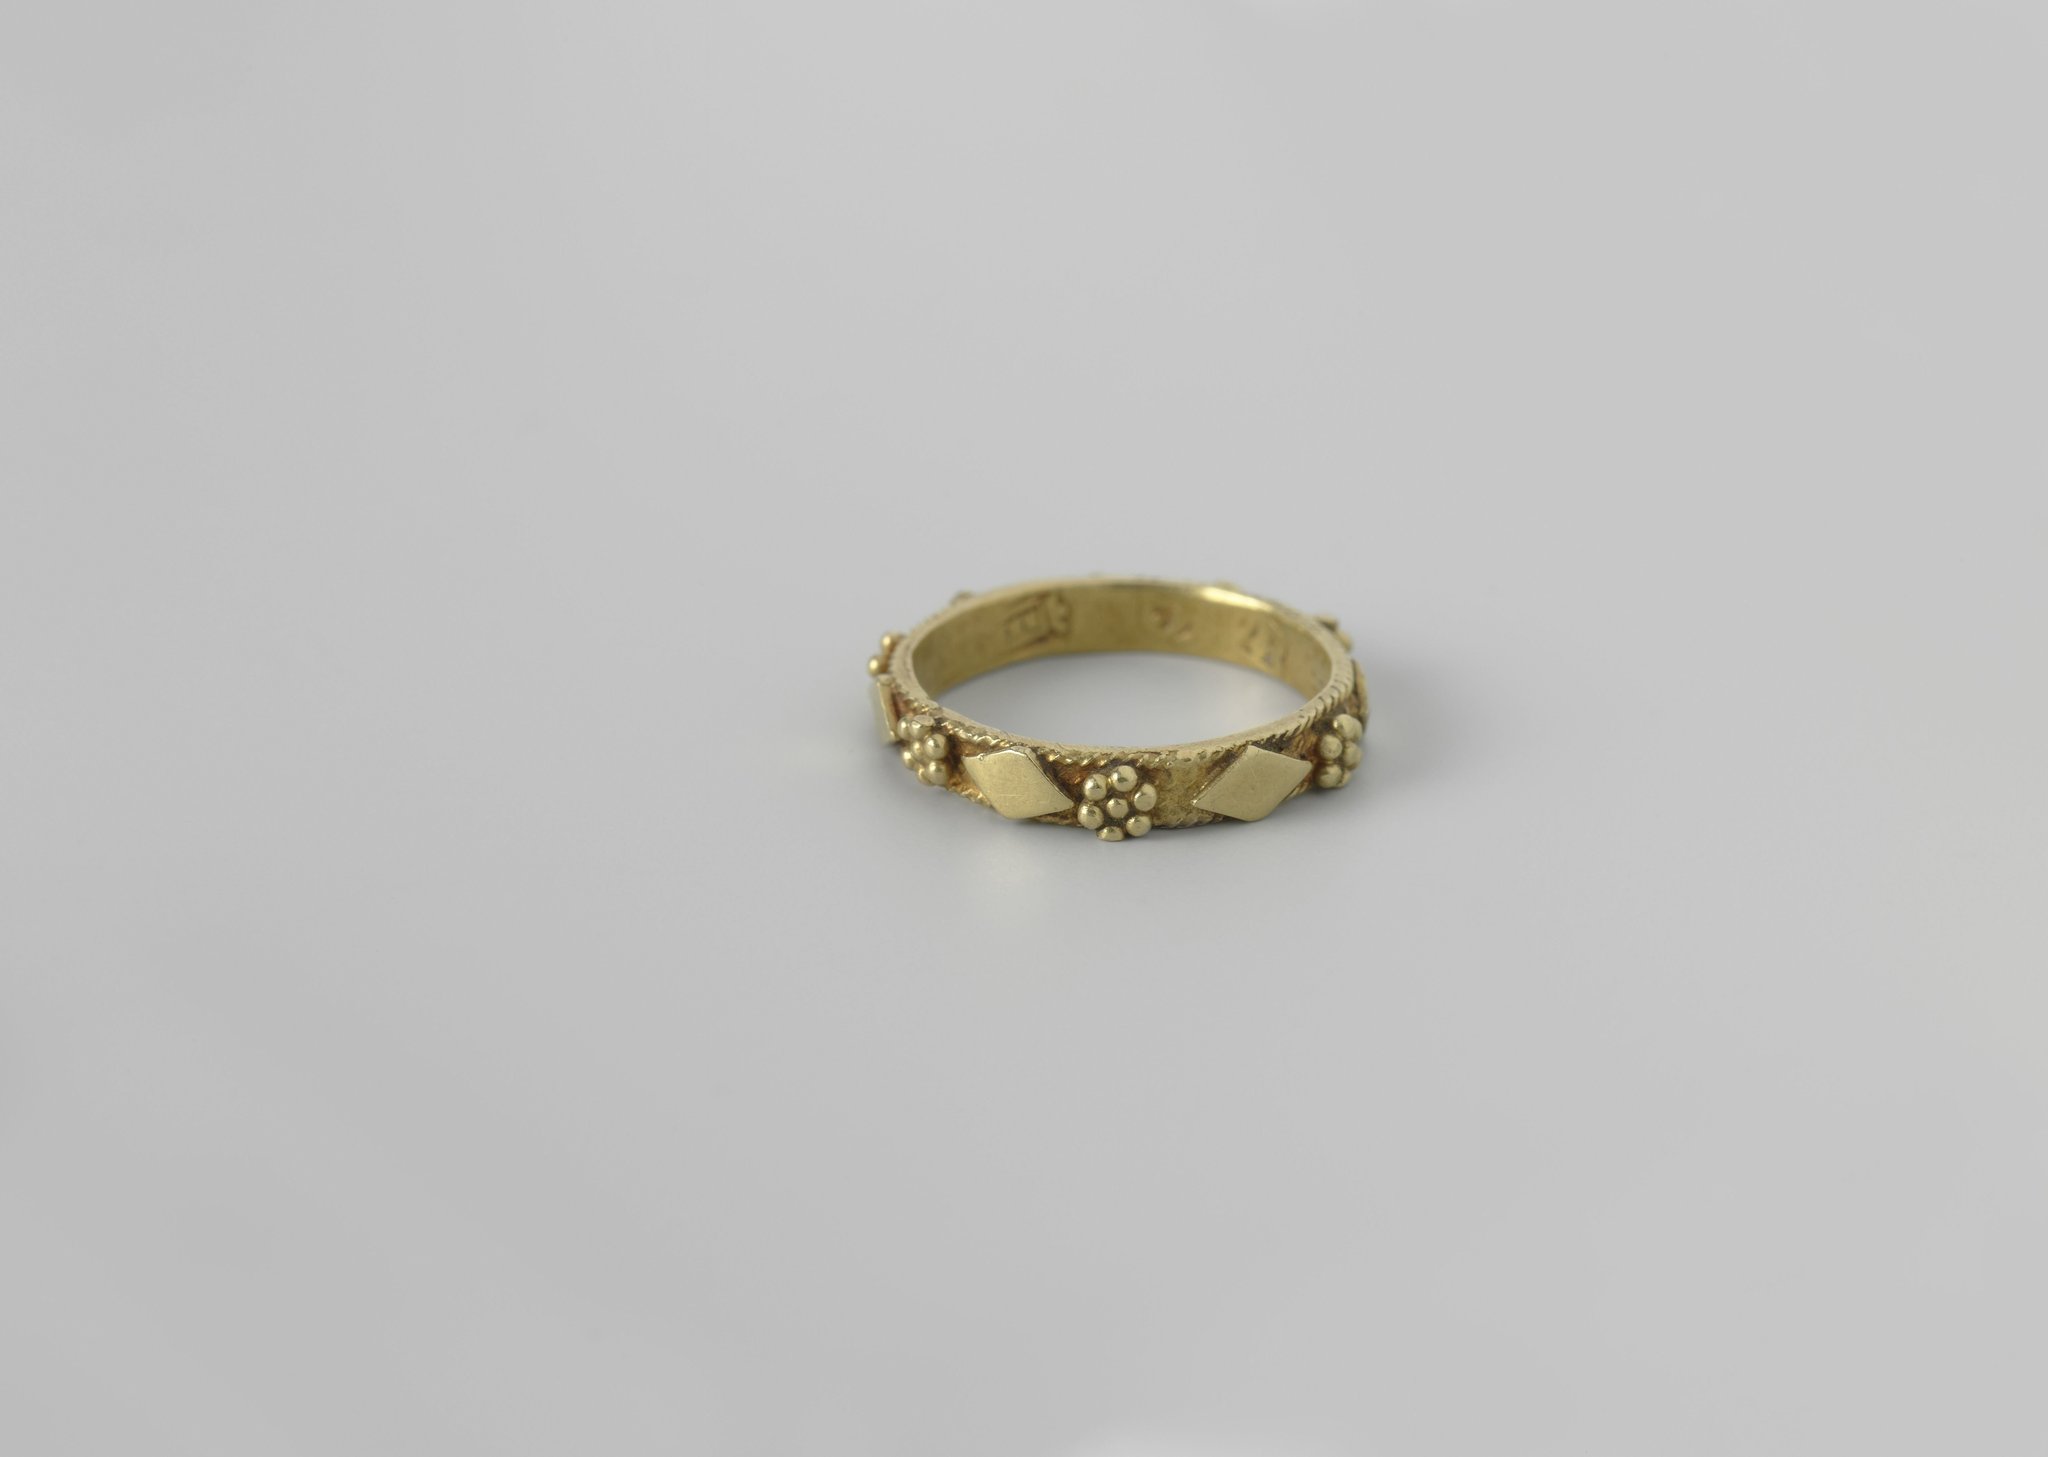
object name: ring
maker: Anonymous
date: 1736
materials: gold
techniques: filigree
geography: amsterdam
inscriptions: maker's mark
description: Gouden ring, versierd met ruiten en sterren.